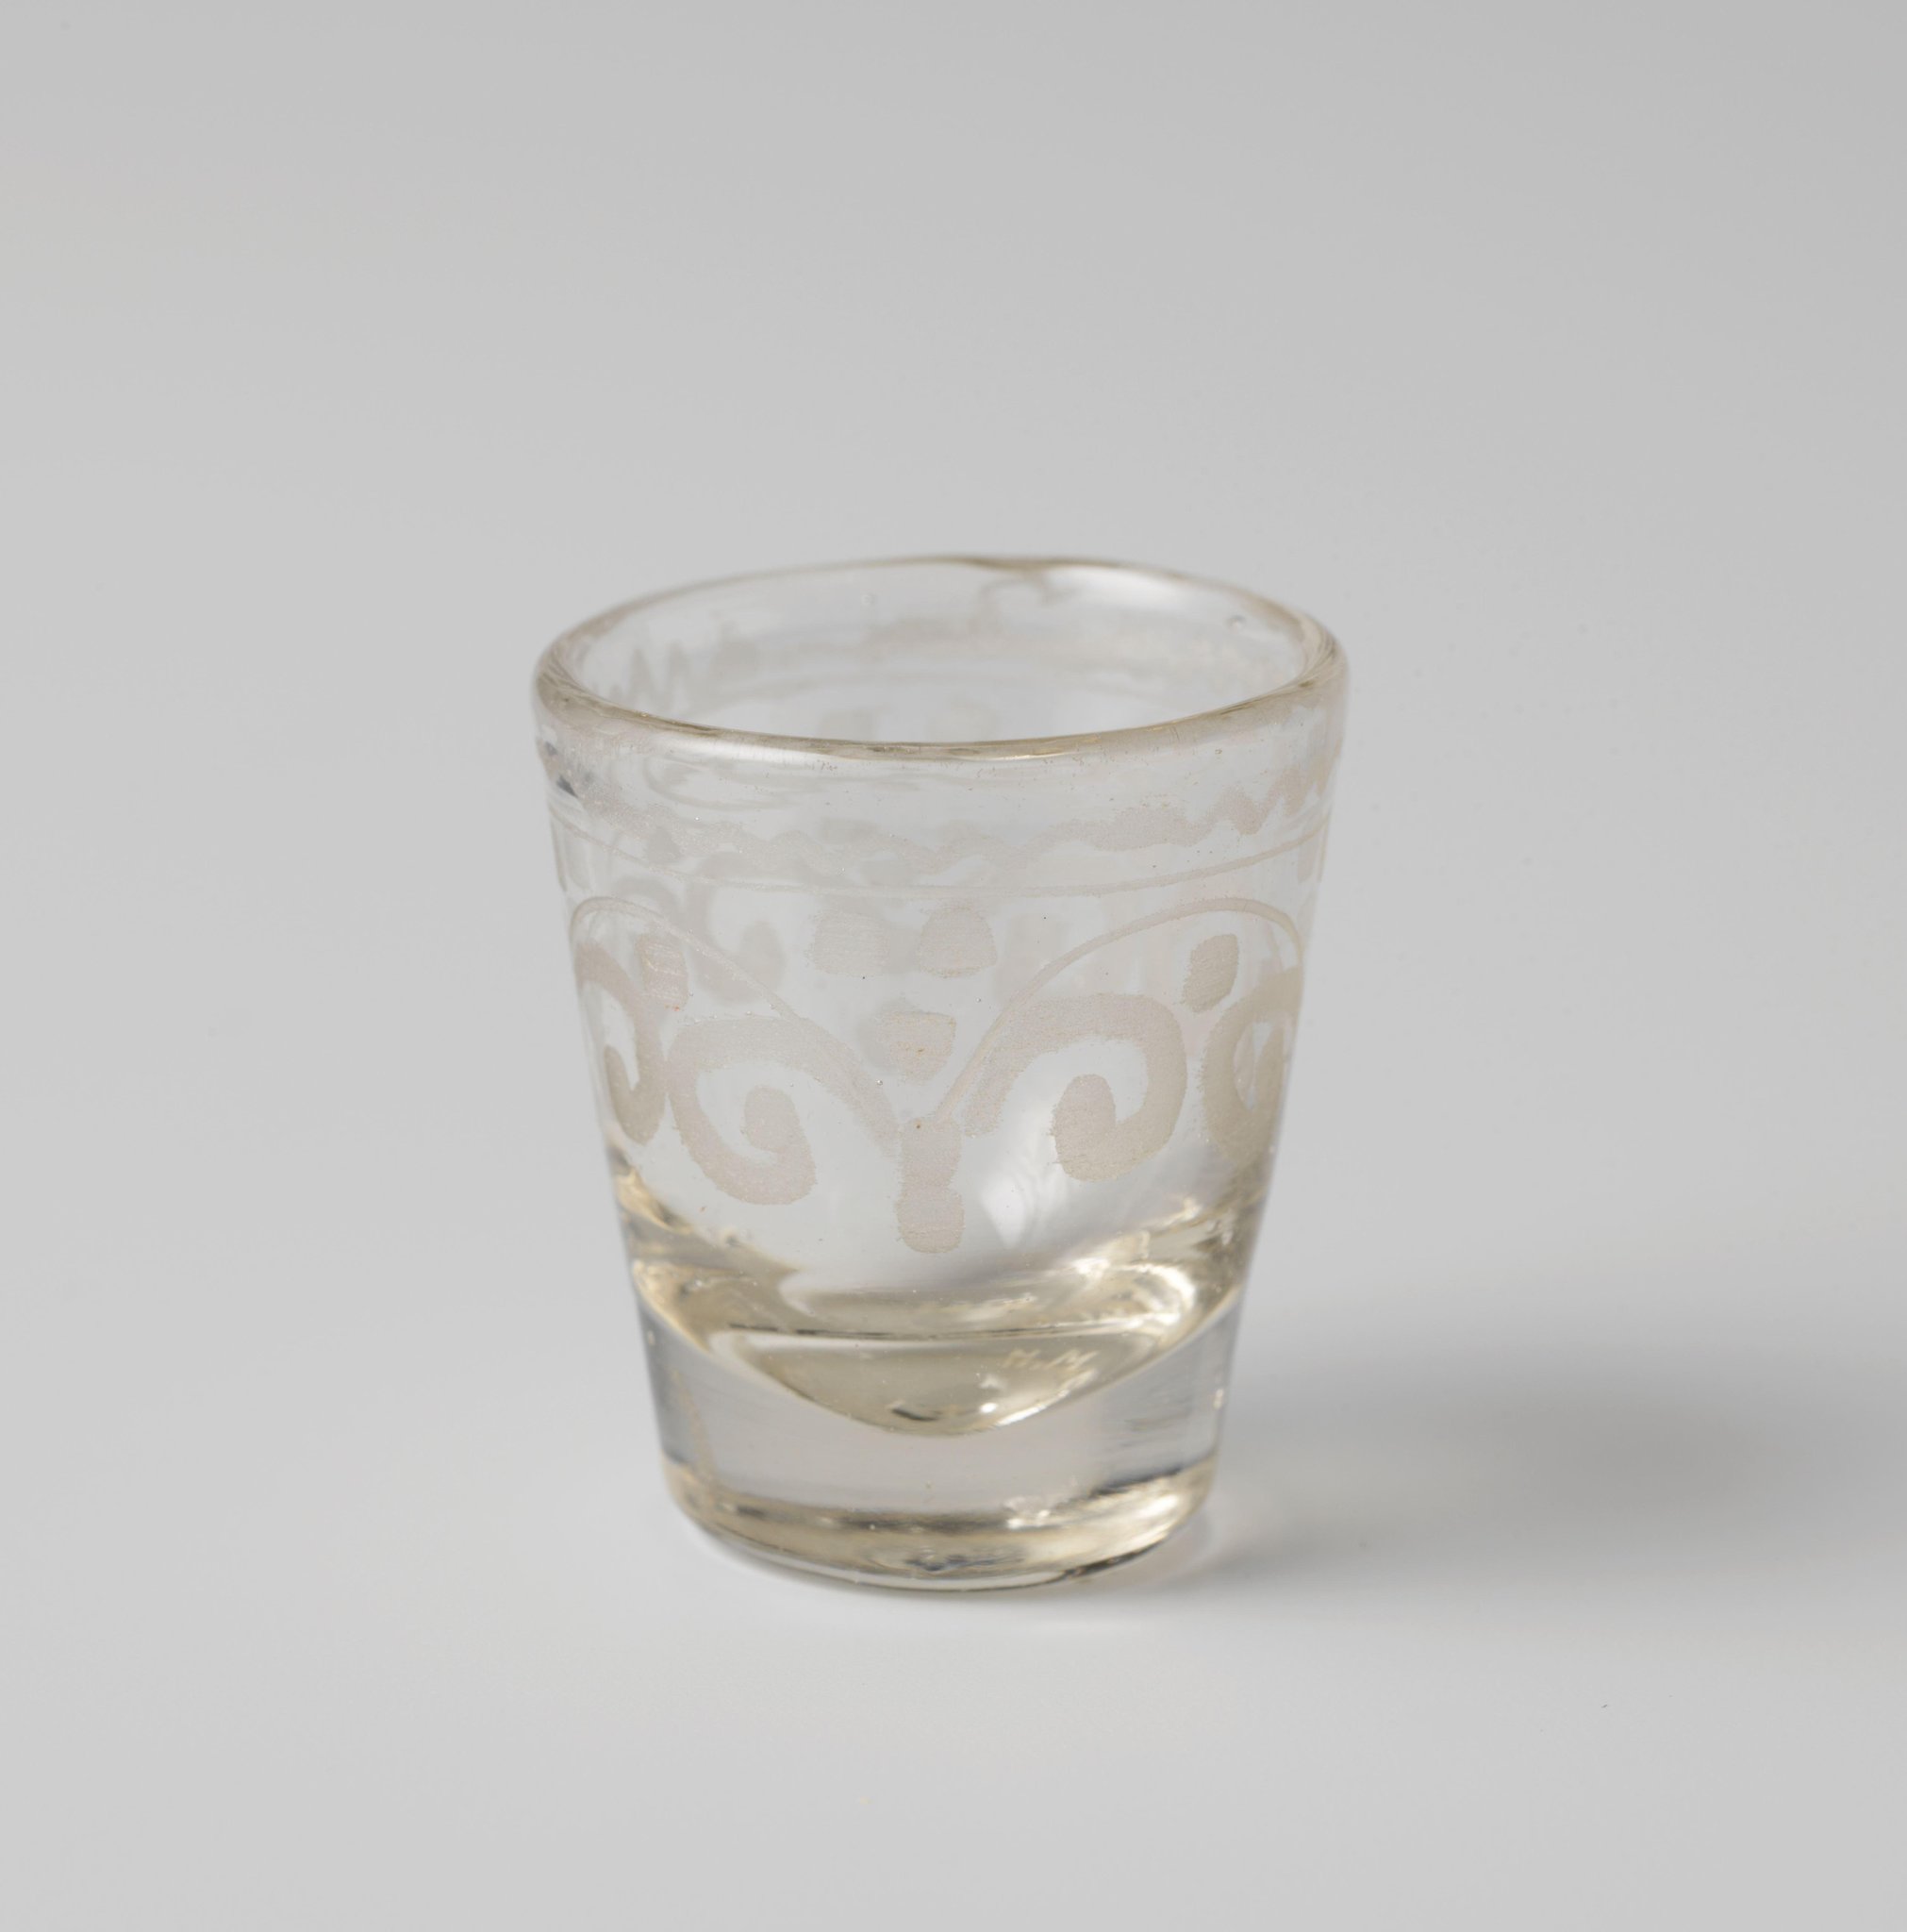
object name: cup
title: Beker gedecoreerd met gegraveerde zigzagrand boven voluten en bollen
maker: Anonymous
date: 1750-1800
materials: glass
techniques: engraving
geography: germany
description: Beker van helder kleurloos glas met massieve bodem; decoratie in radgravure: zigzagrand boven voluten en bollen.